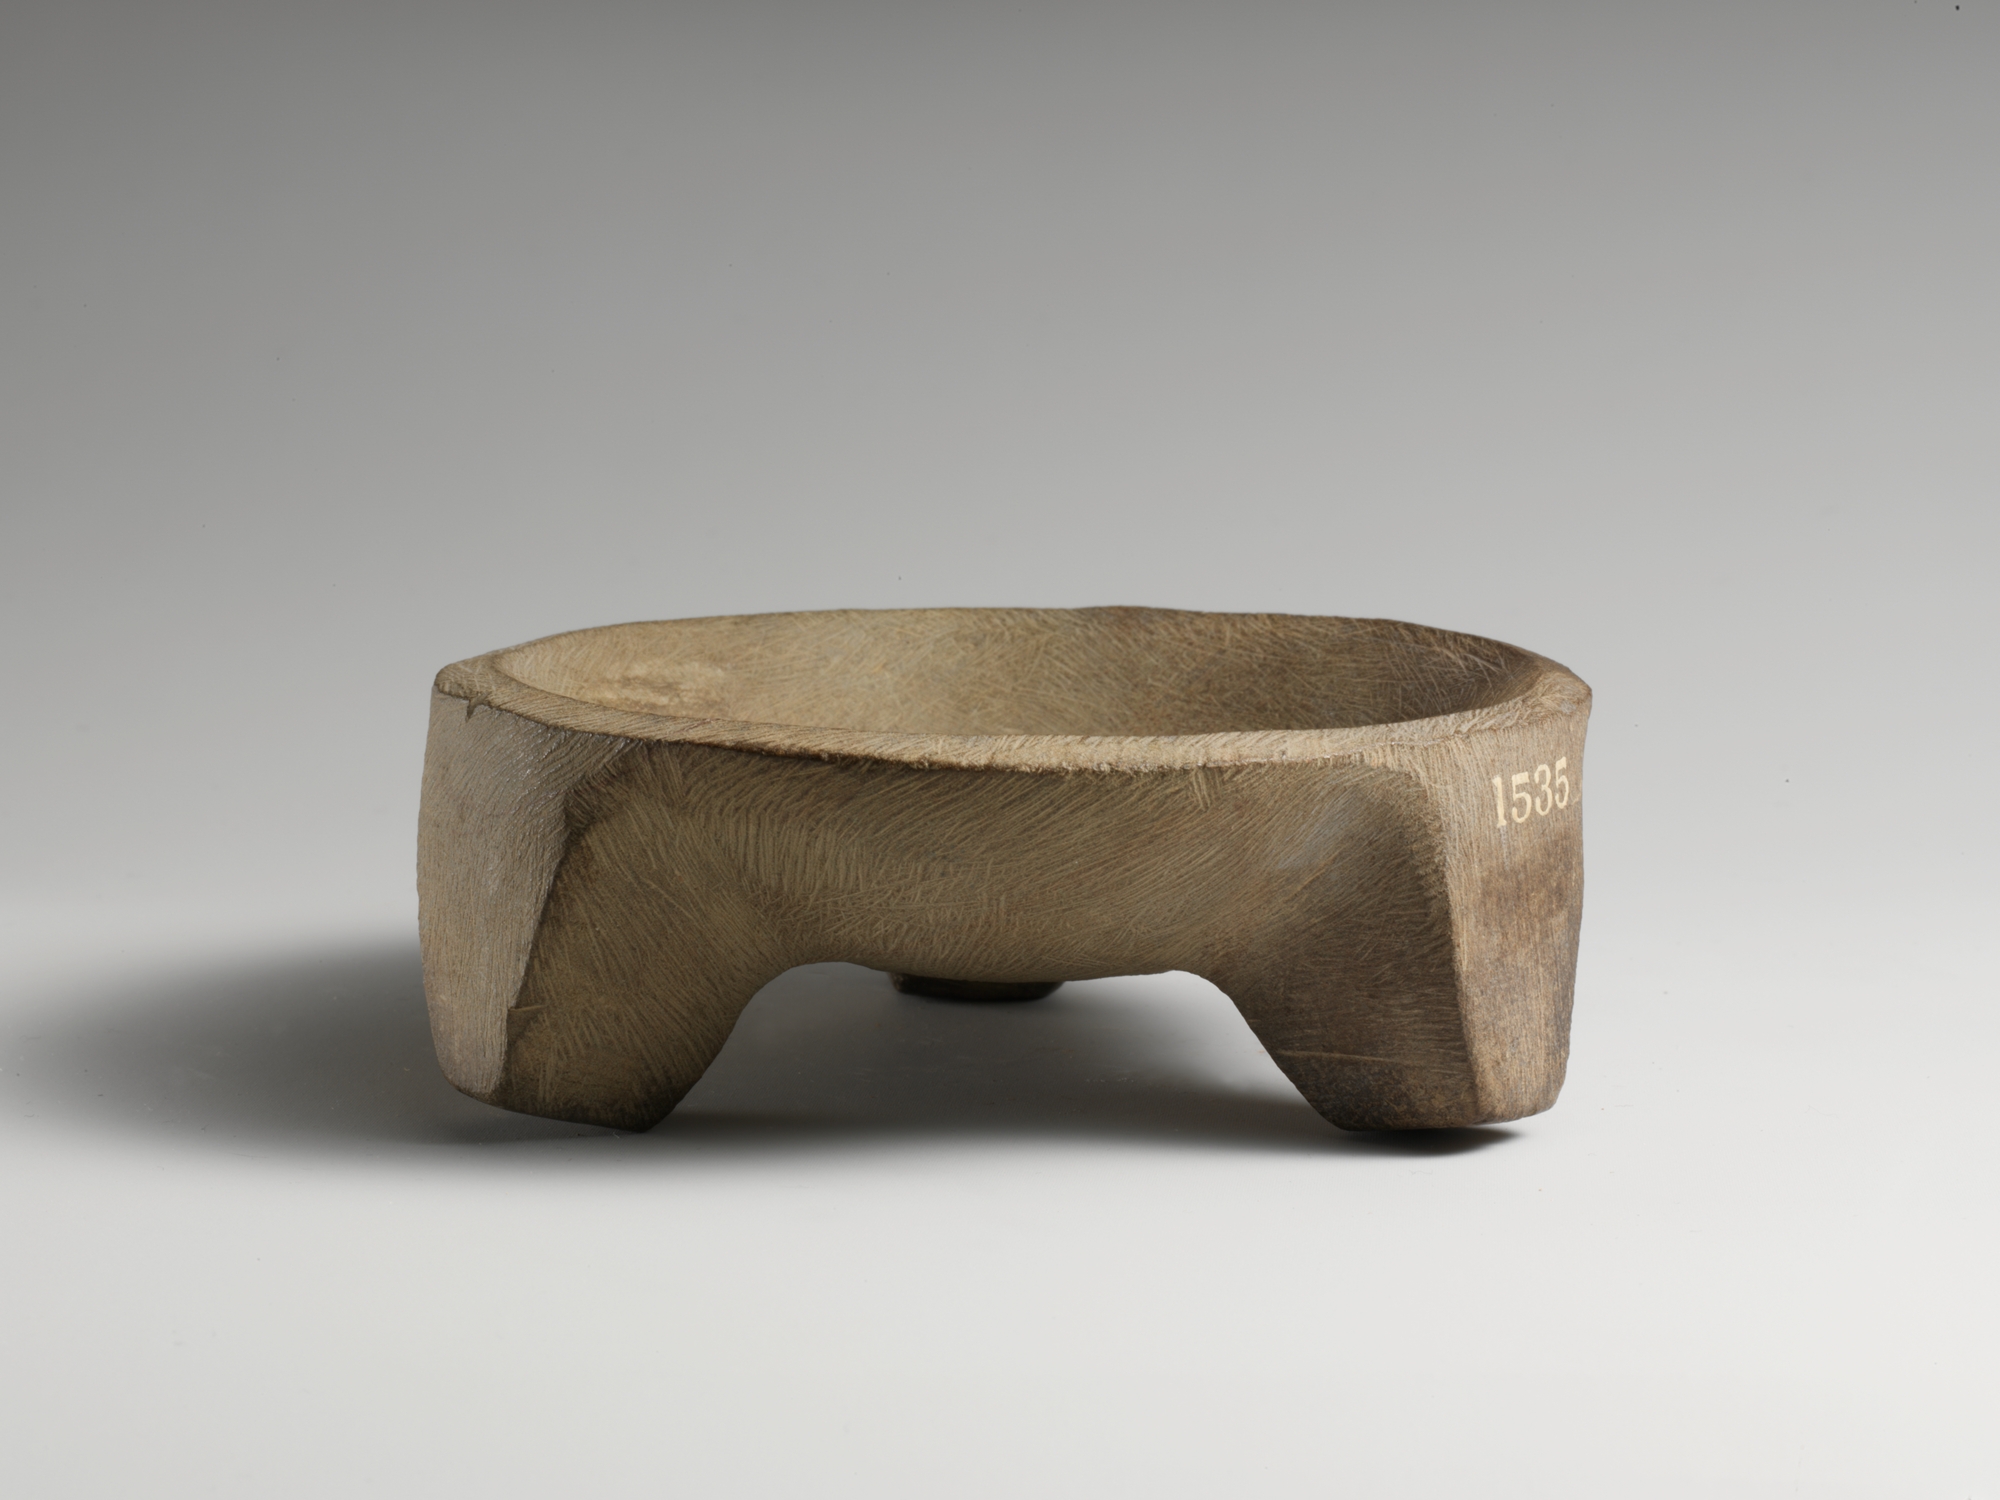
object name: bowl, shallow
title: Chlorite mortar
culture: cypriot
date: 1600-700 BCE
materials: mineral